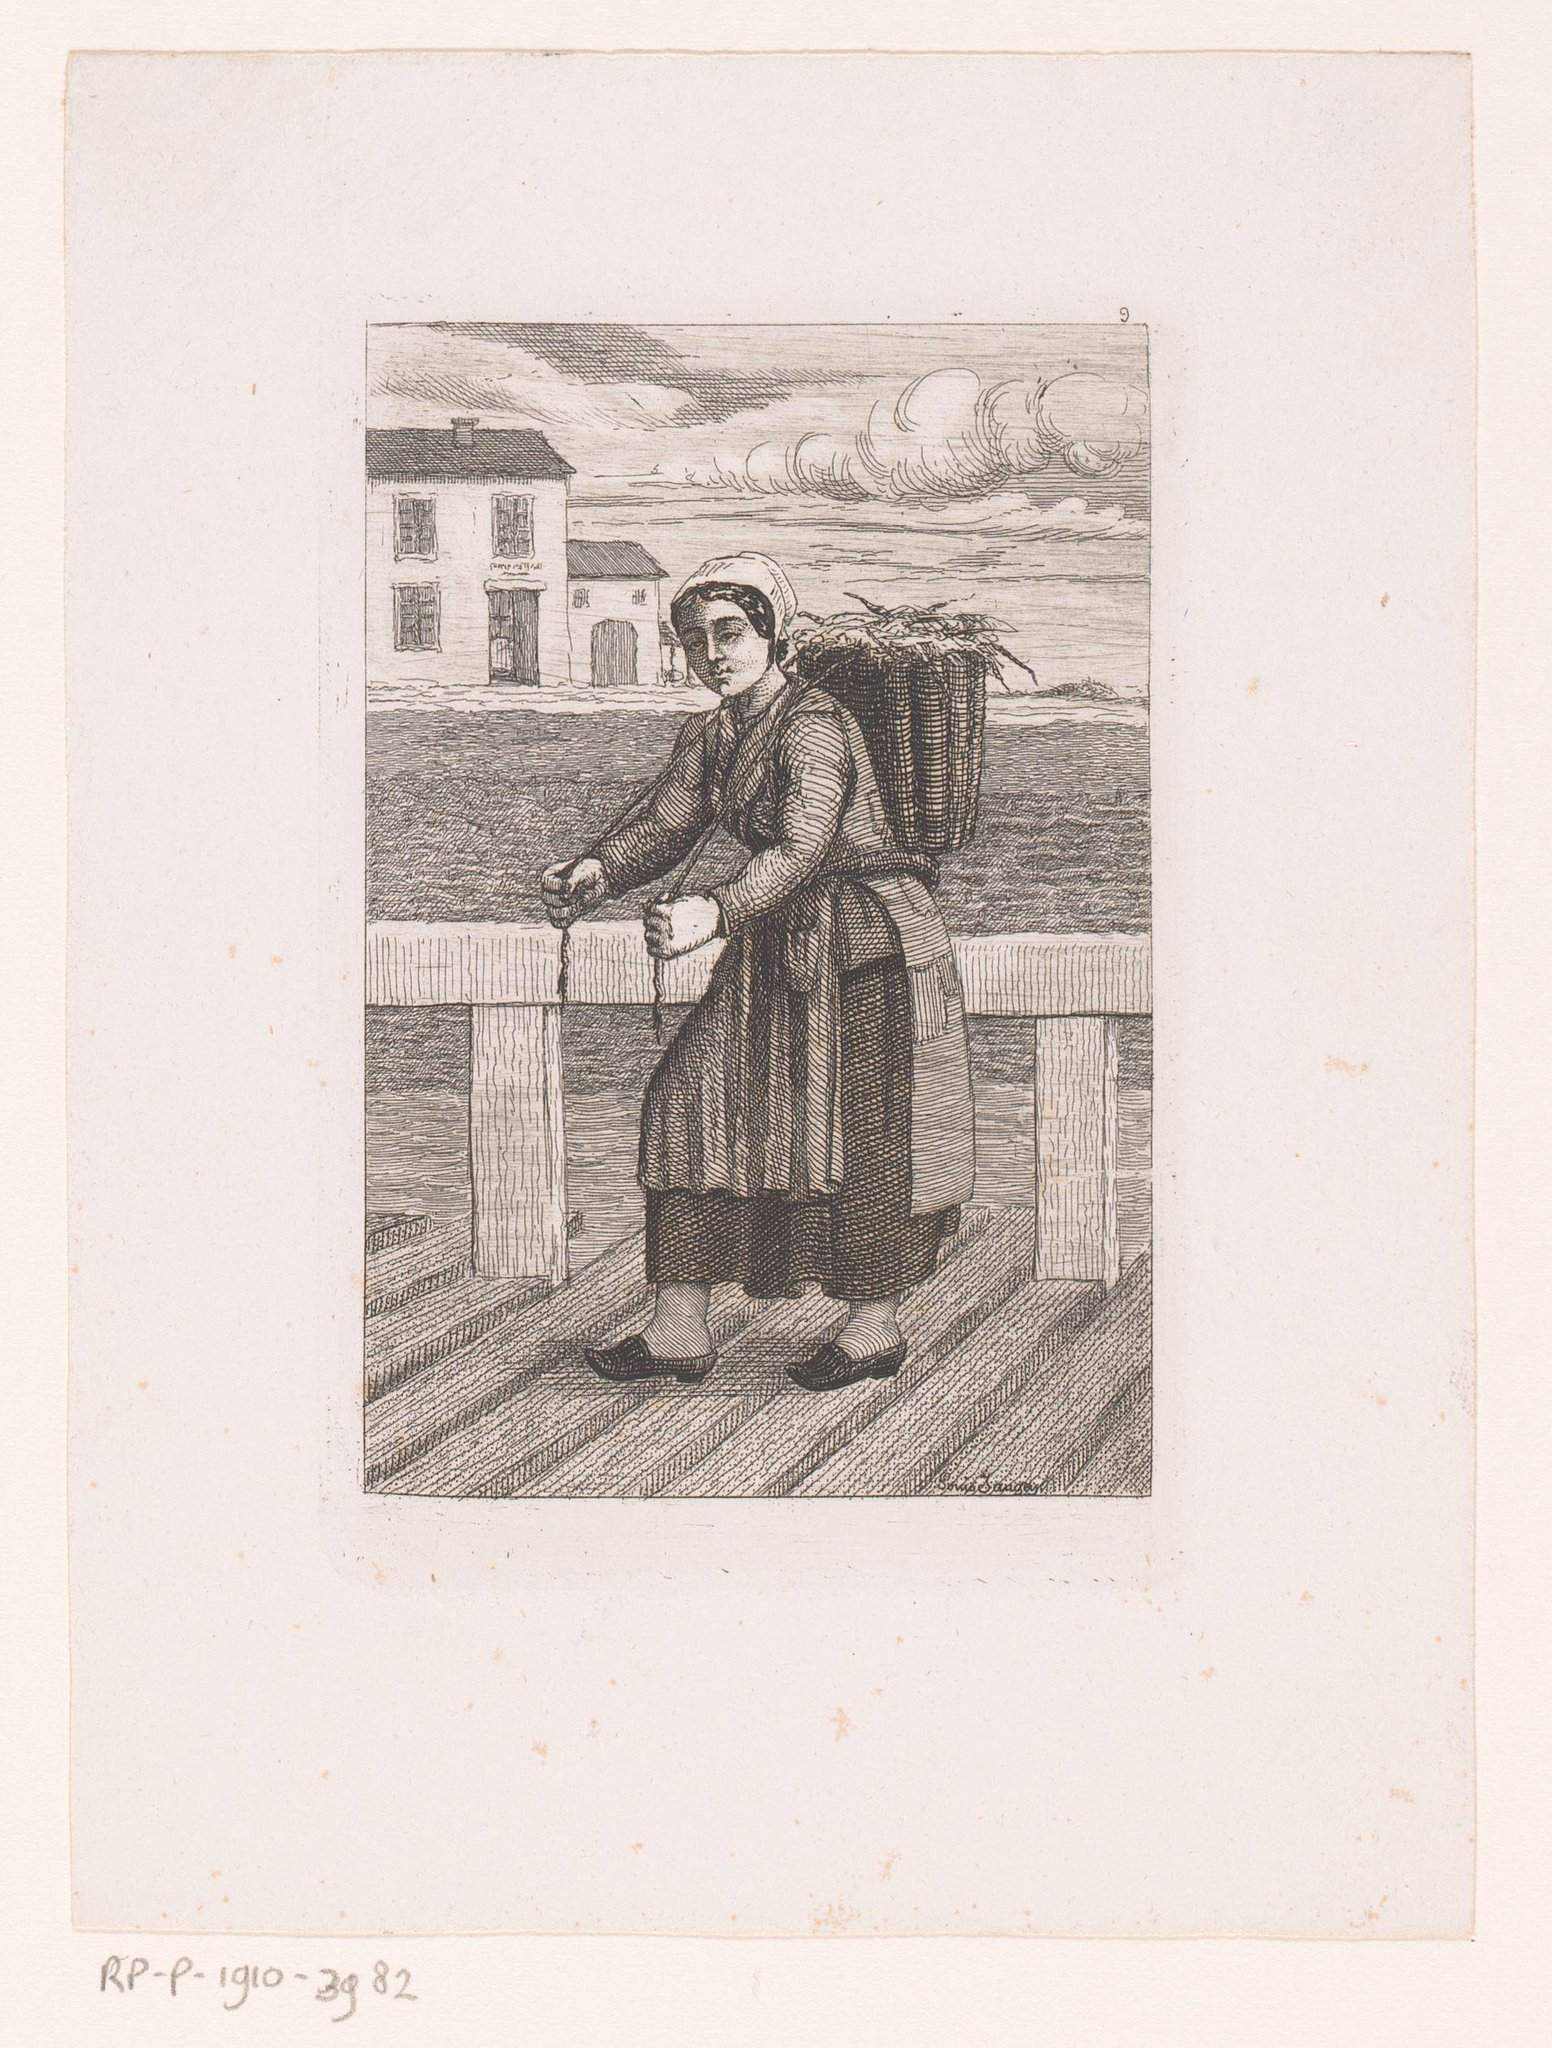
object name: print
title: Vrouw met mand op de rug loopt langs het water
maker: louis jaugey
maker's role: print maker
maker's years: 1837-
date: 1850-1899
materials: paper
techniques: etching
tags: adult woman, carrying something in basket, bag, rucksack, etc., pier, quay, wharf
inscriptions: collector's mark: Lugt 2228